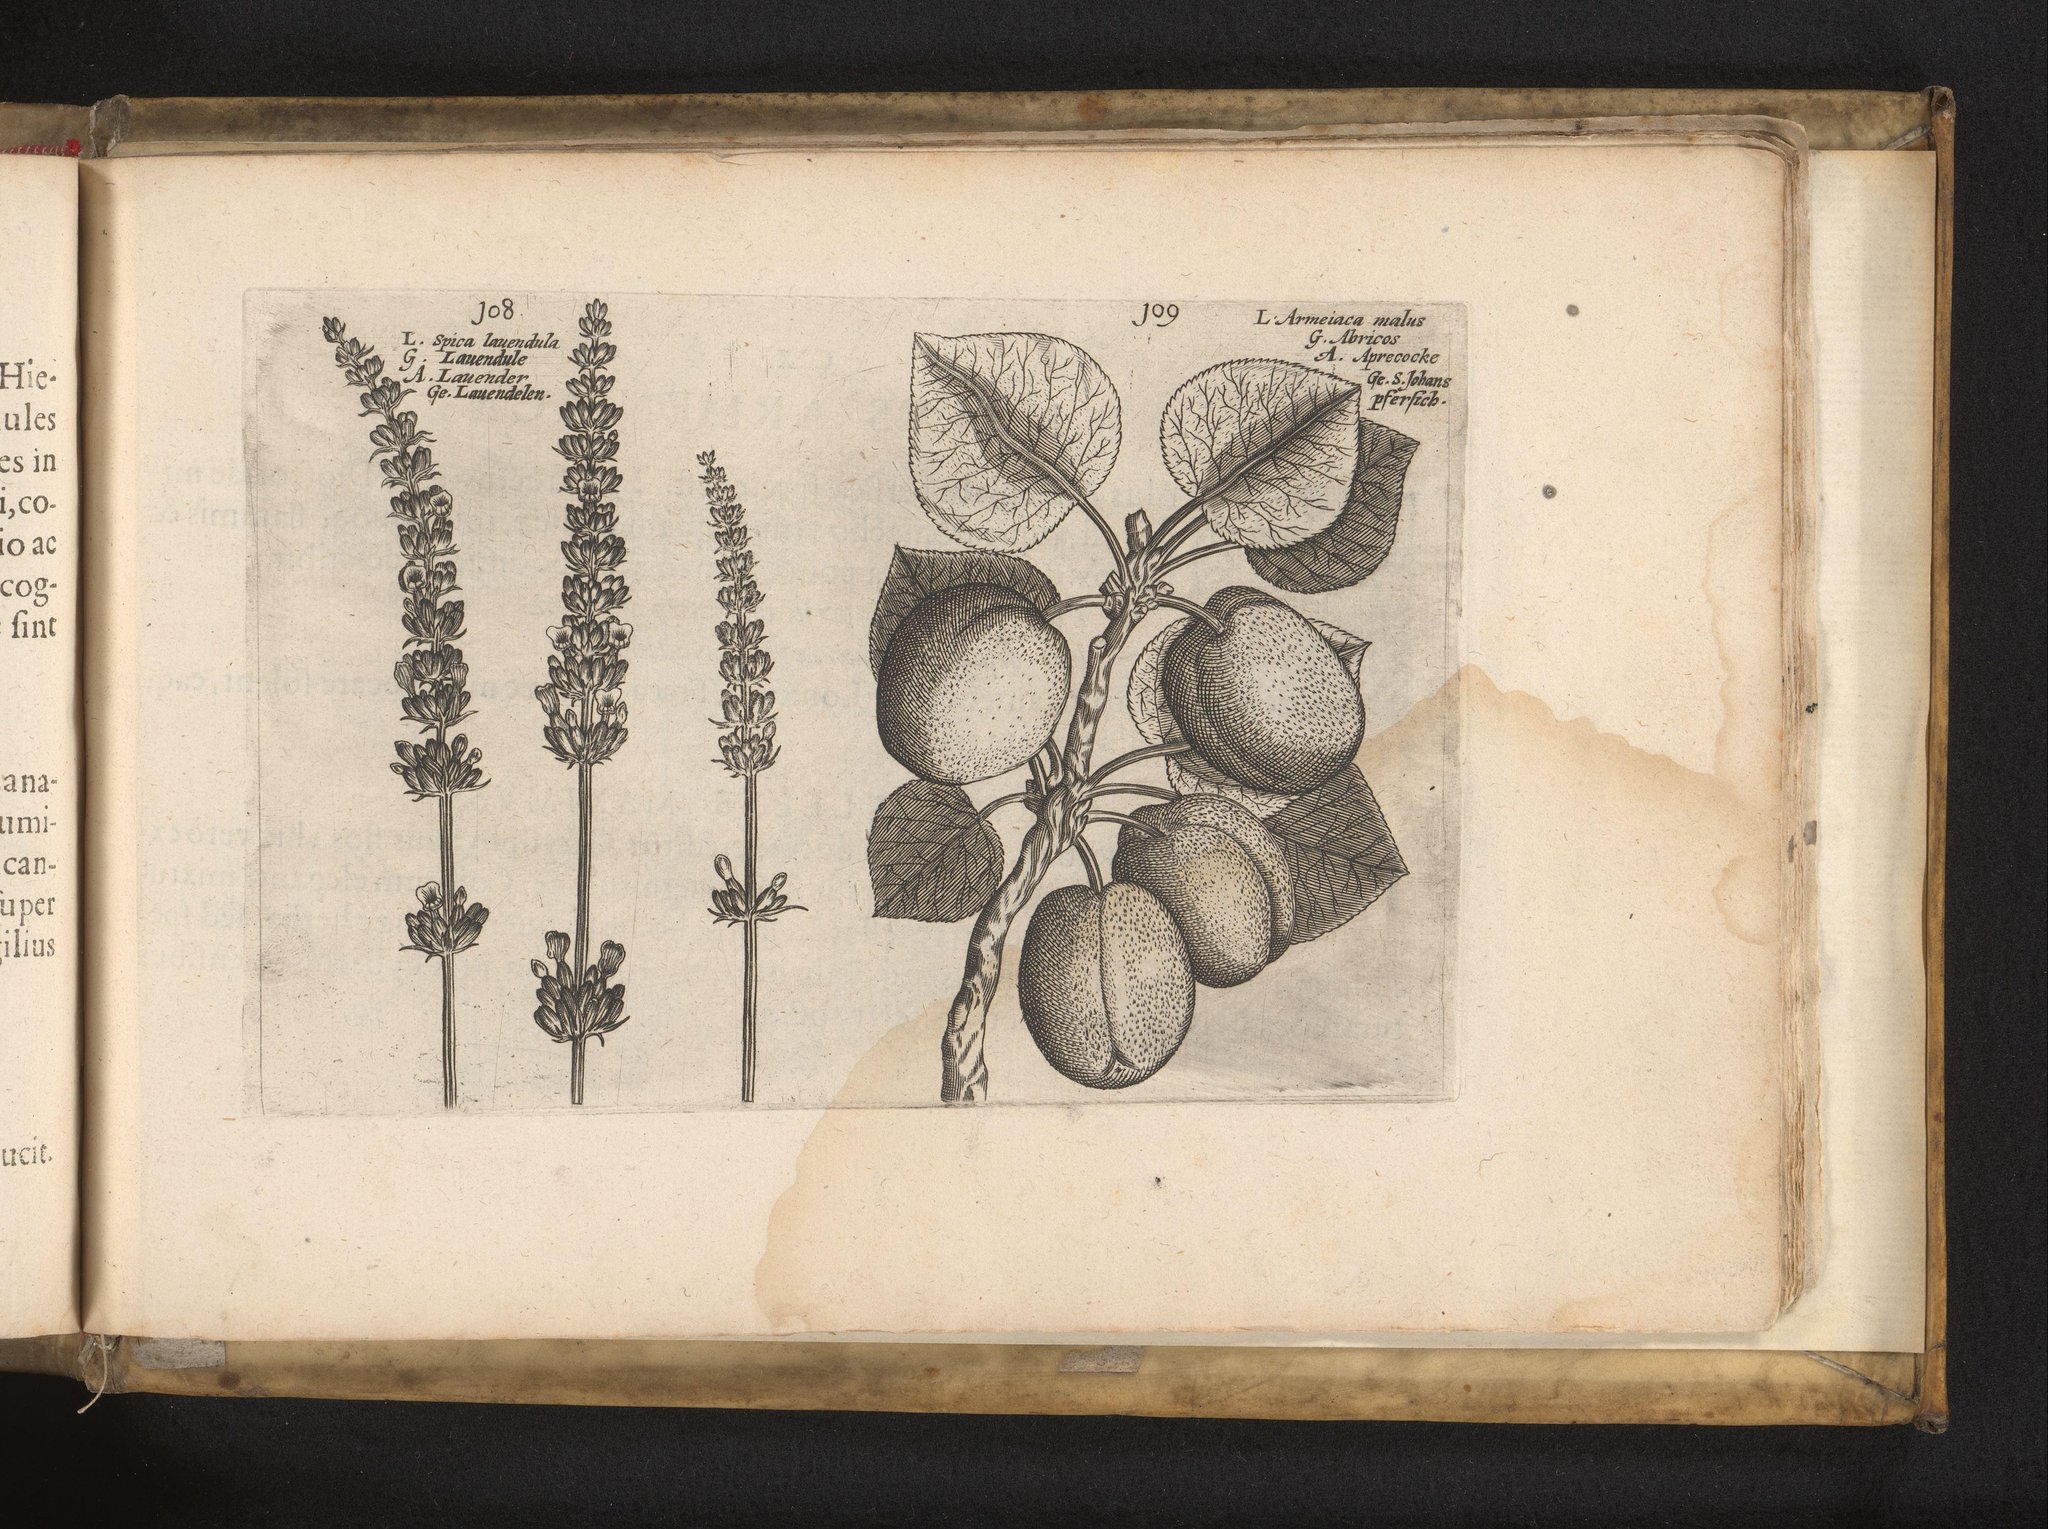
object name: page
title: Spica lavendula / Lavendule / Lavender / Lavendelen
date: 1617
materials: paper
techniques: engraving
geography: arnhem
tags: flowers, fruits: apricot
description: Prent uit: Passe, Crispijn van de (II). Hortus floridus in quo rariorum & minus vulgarium florum icones ad vivam veramque formam. Arnhem: Johannes Janssonius, 1617.